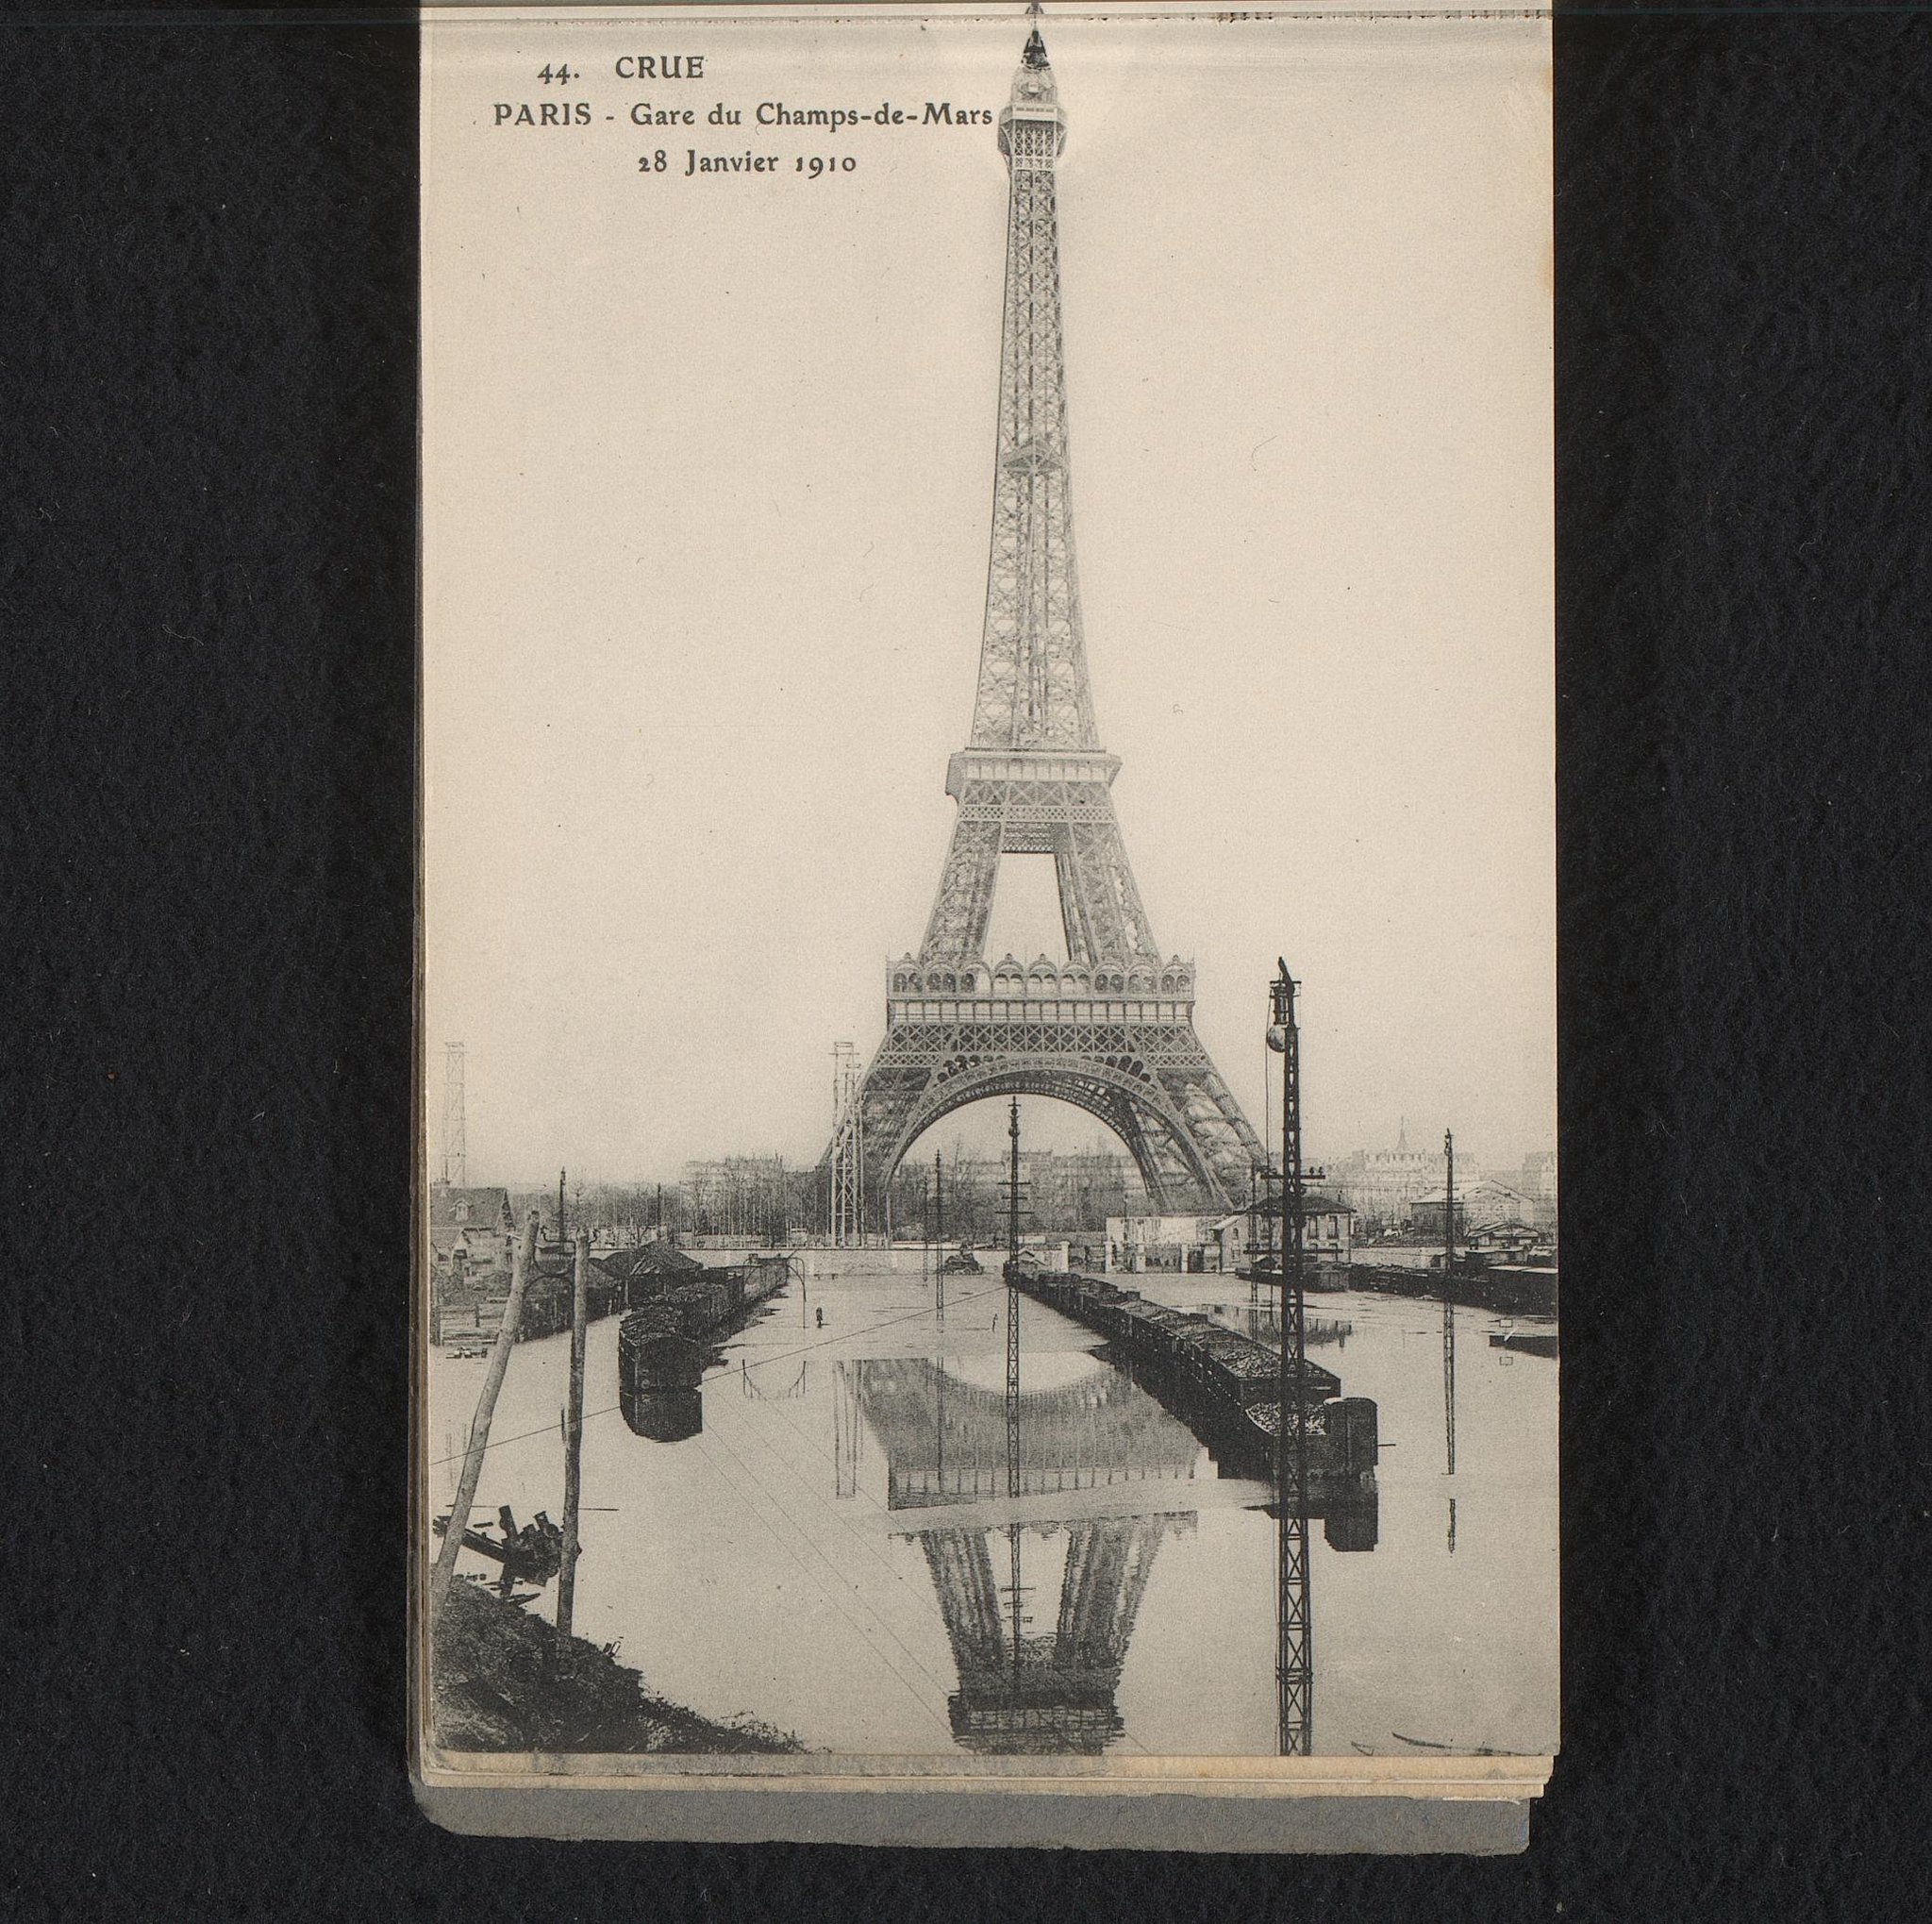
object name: ansichtkaart, prentbriefkaart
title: Paris. Gare du Champs-de-Mars. 28 Janvier 1910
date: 1910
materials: cardboard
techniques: photograph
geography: paris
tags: city-view, and landscape with man-made constructions, tower, clock tower ~ monumental adornment, flood, eiffel tower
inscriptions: date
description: Prentbriefkaart maakt deel uit van een album.